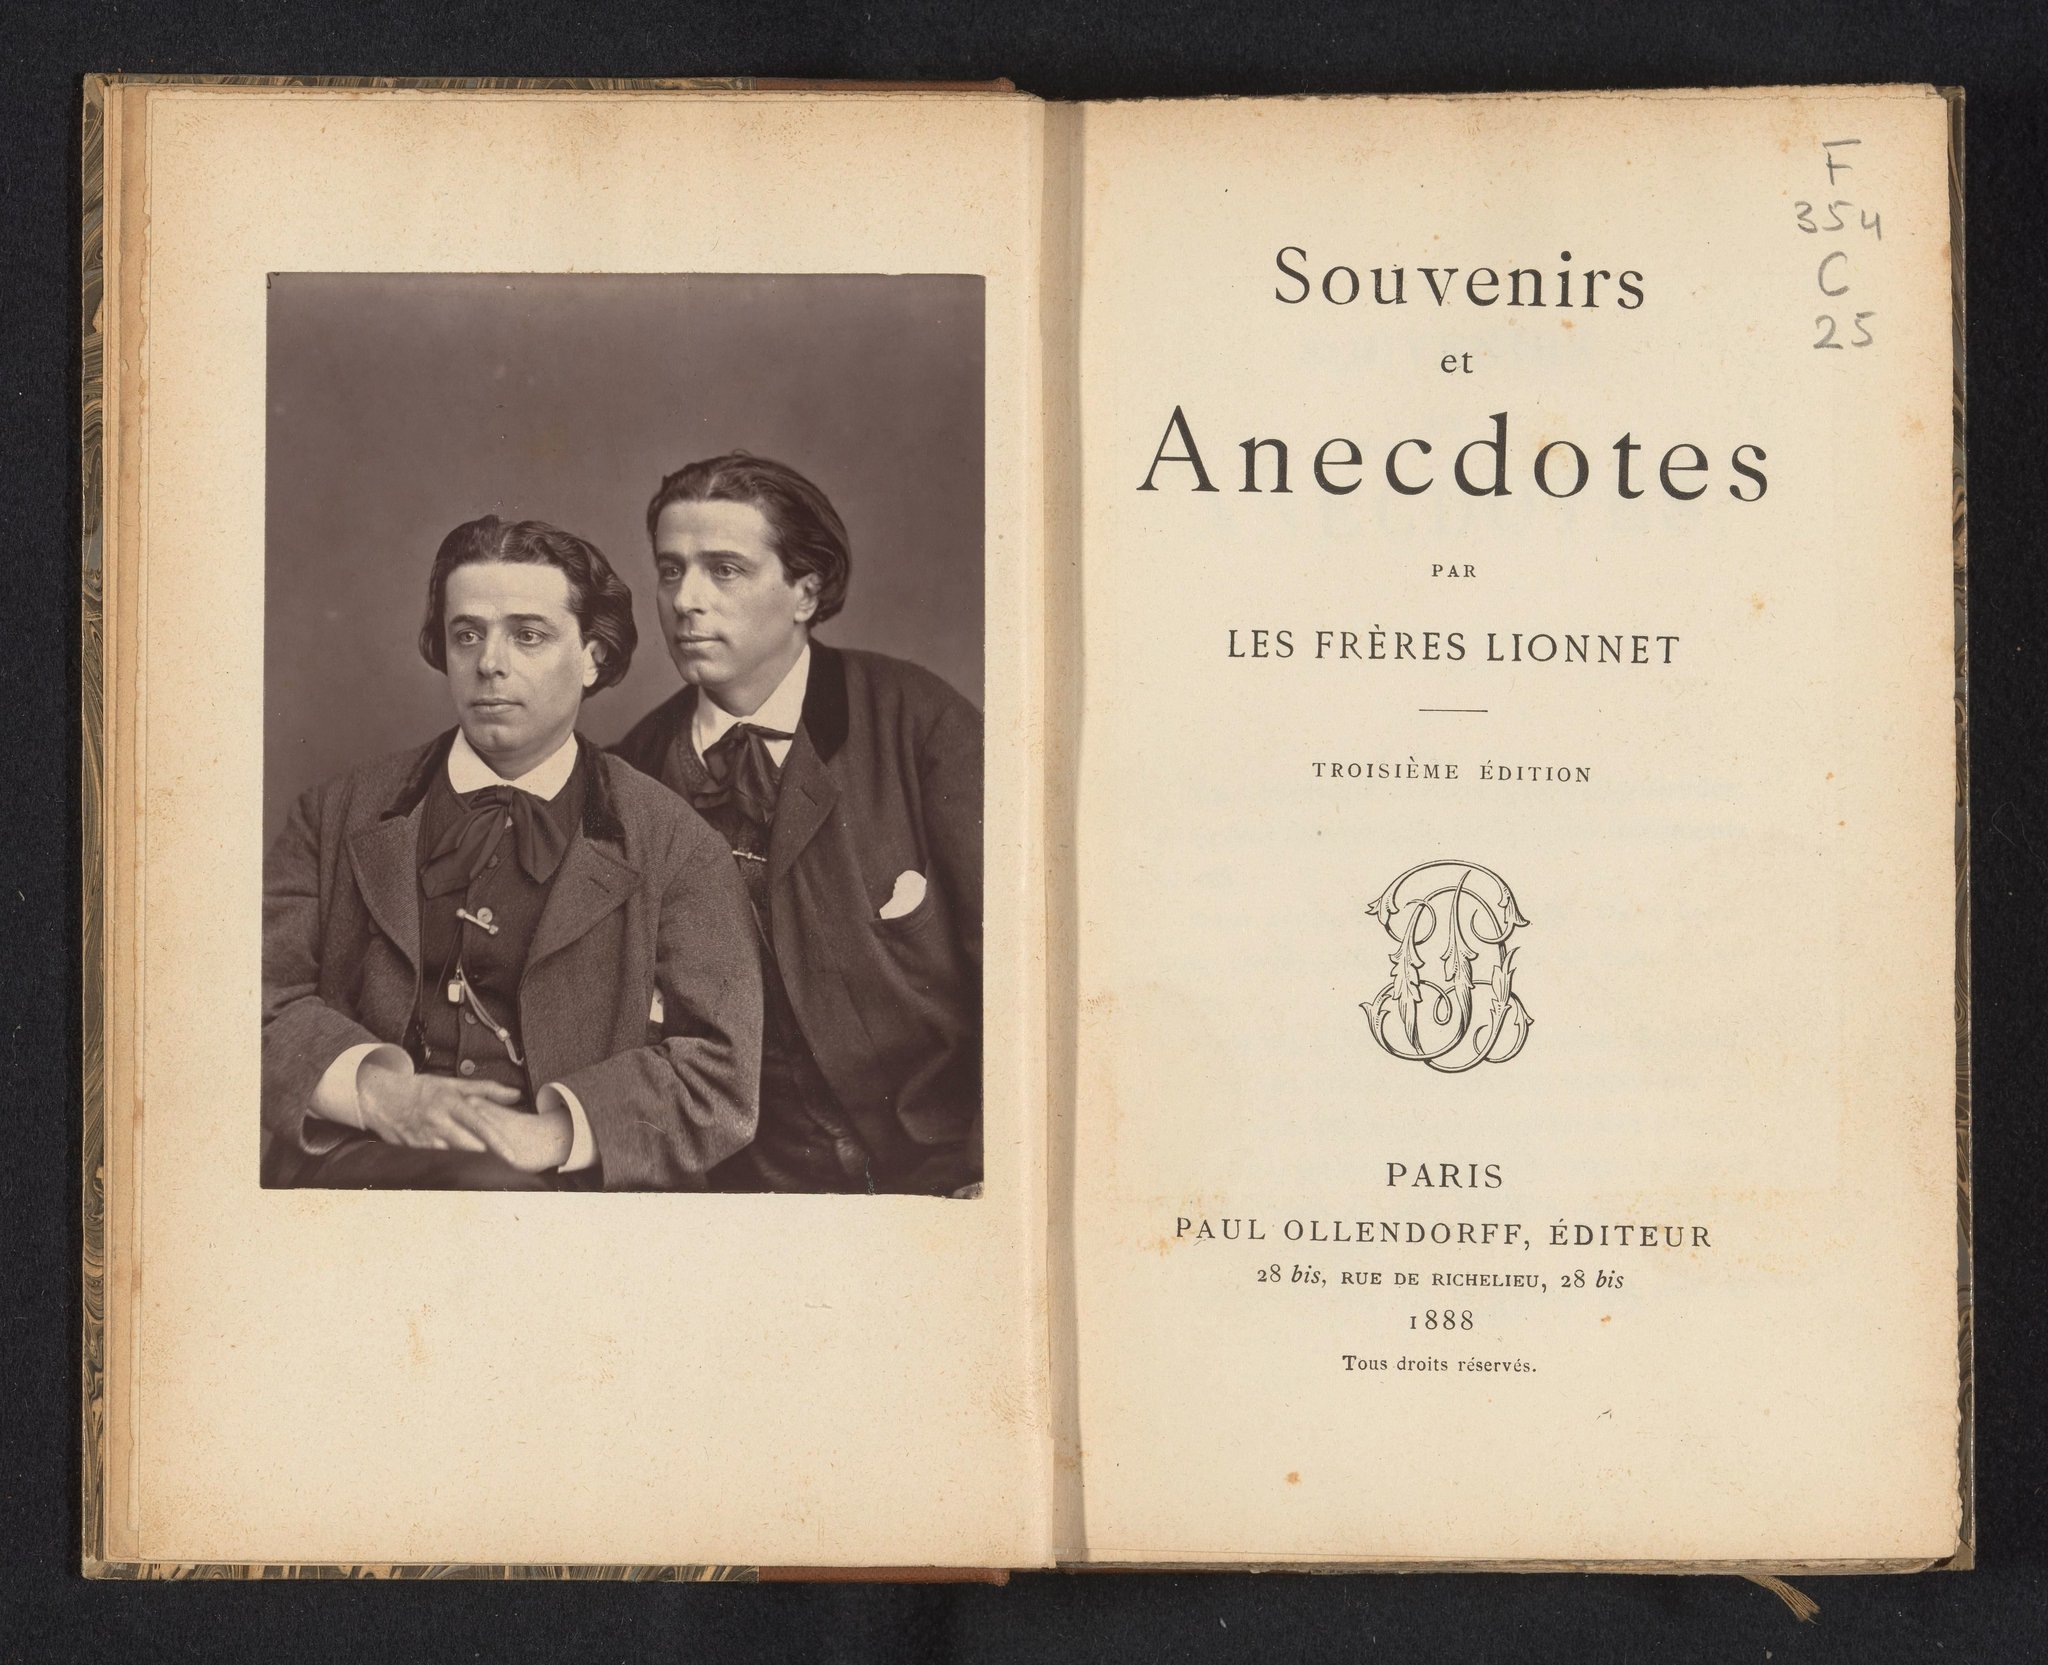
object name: page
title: Portret van de gebroeders Lionnet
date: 1878-1888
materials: paper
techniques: woodburytype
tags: portrait of opera-singer